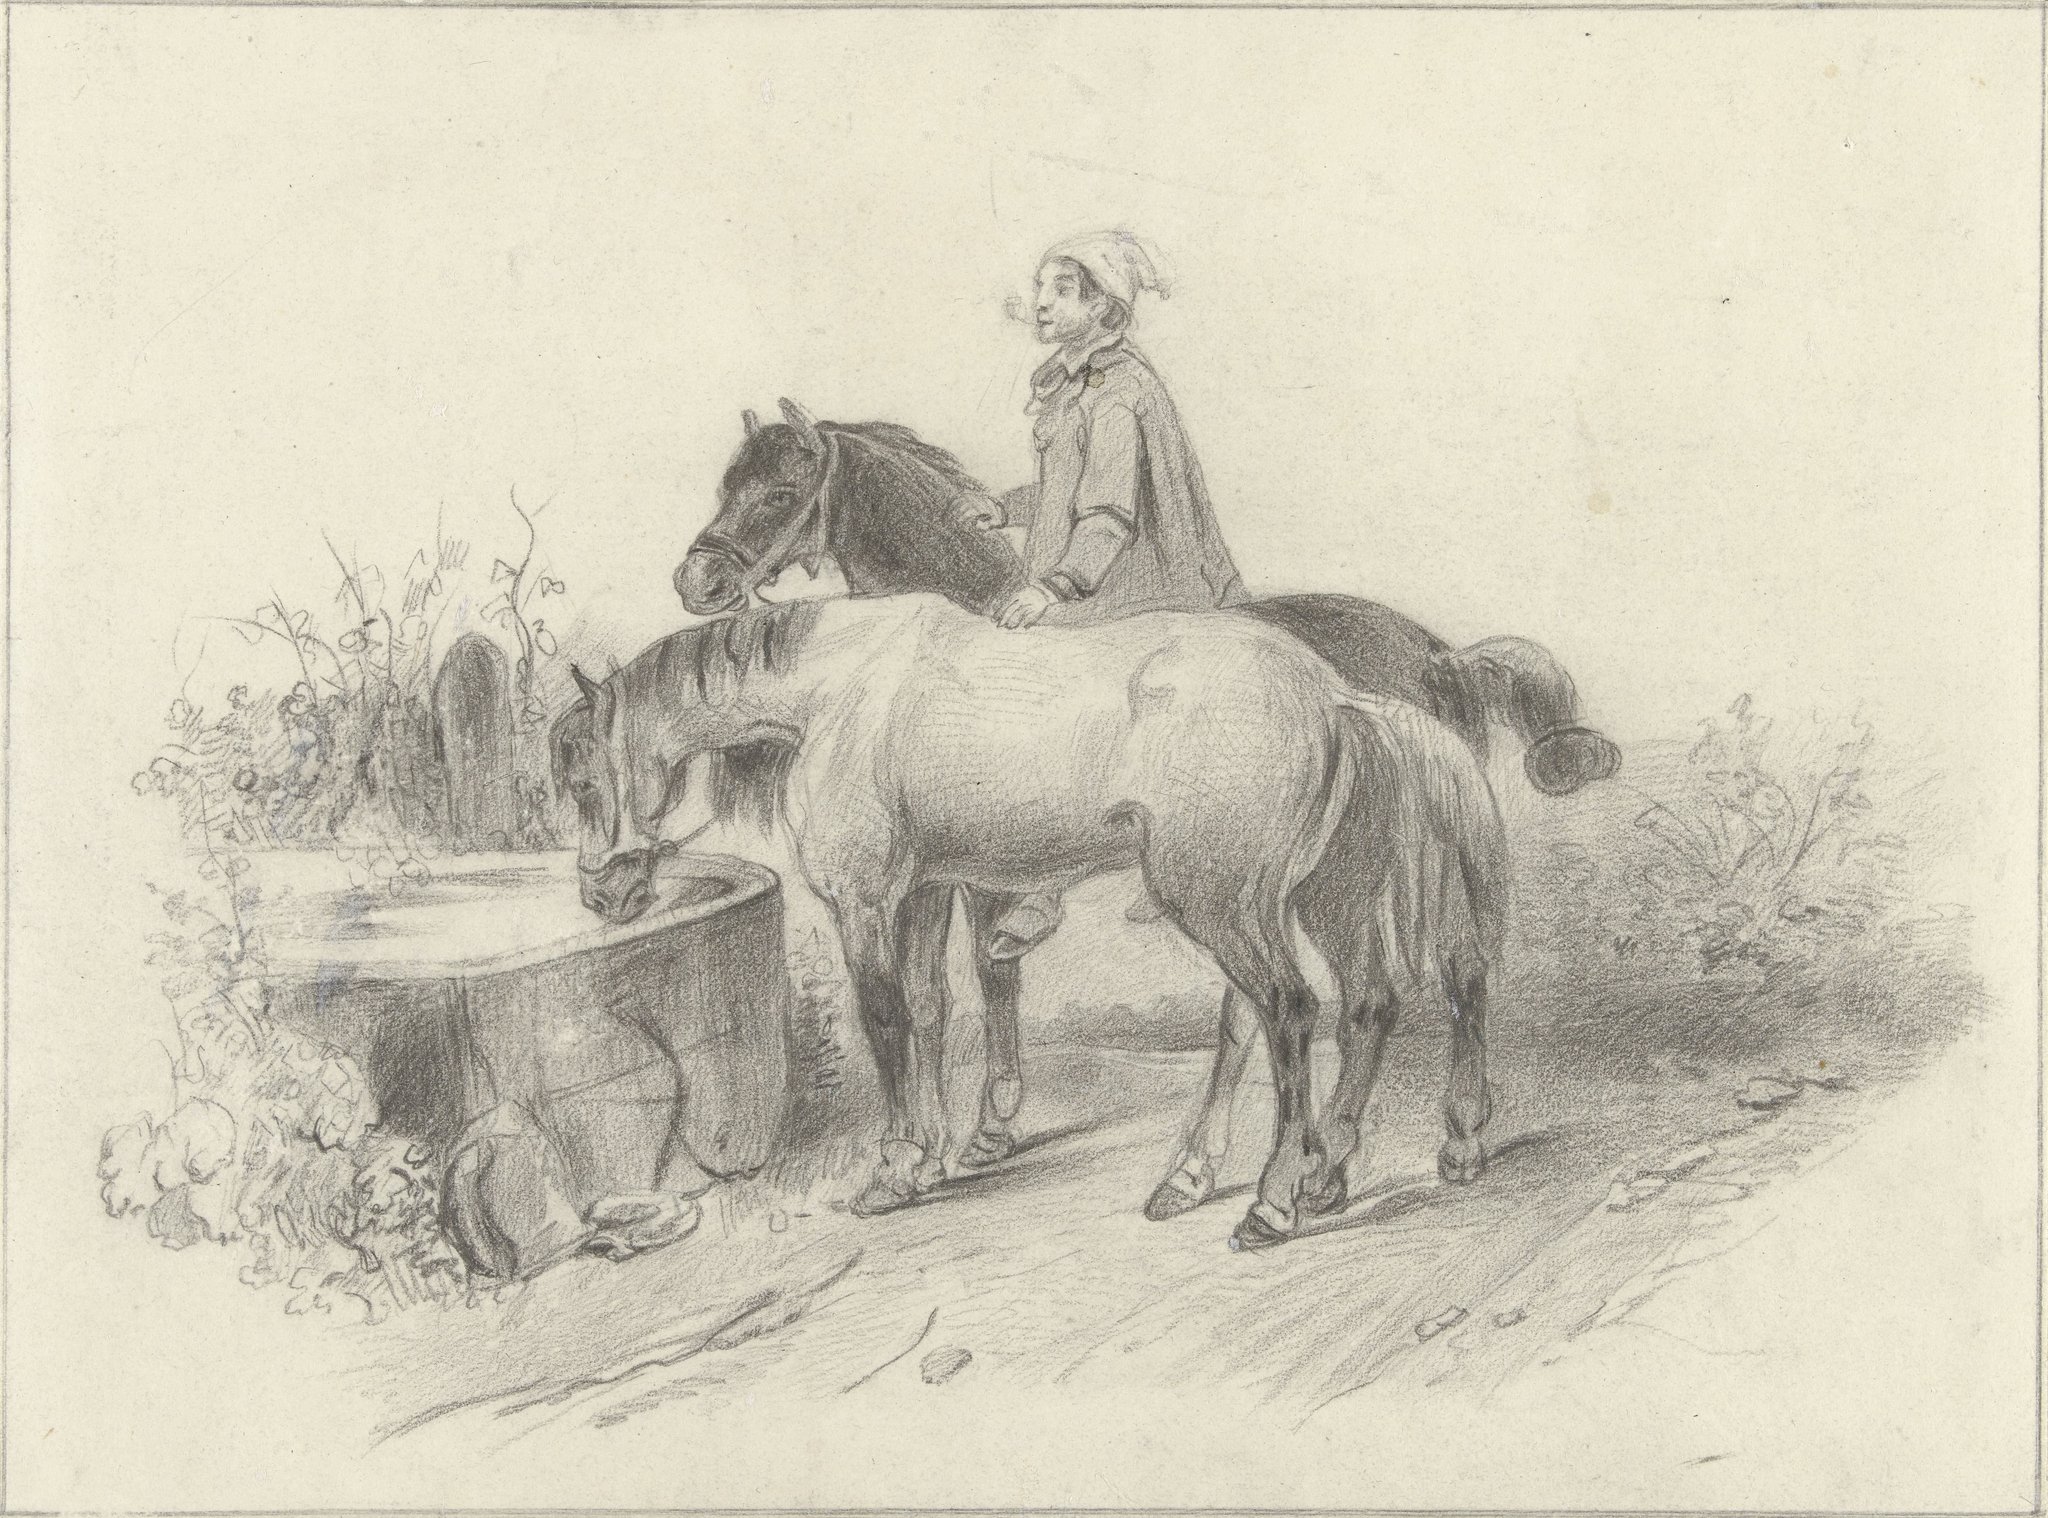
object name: drawing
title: Boer met twee paarden bij een drinkbak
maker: Anonymous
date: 1800-1900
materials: chalk, paper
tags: horse